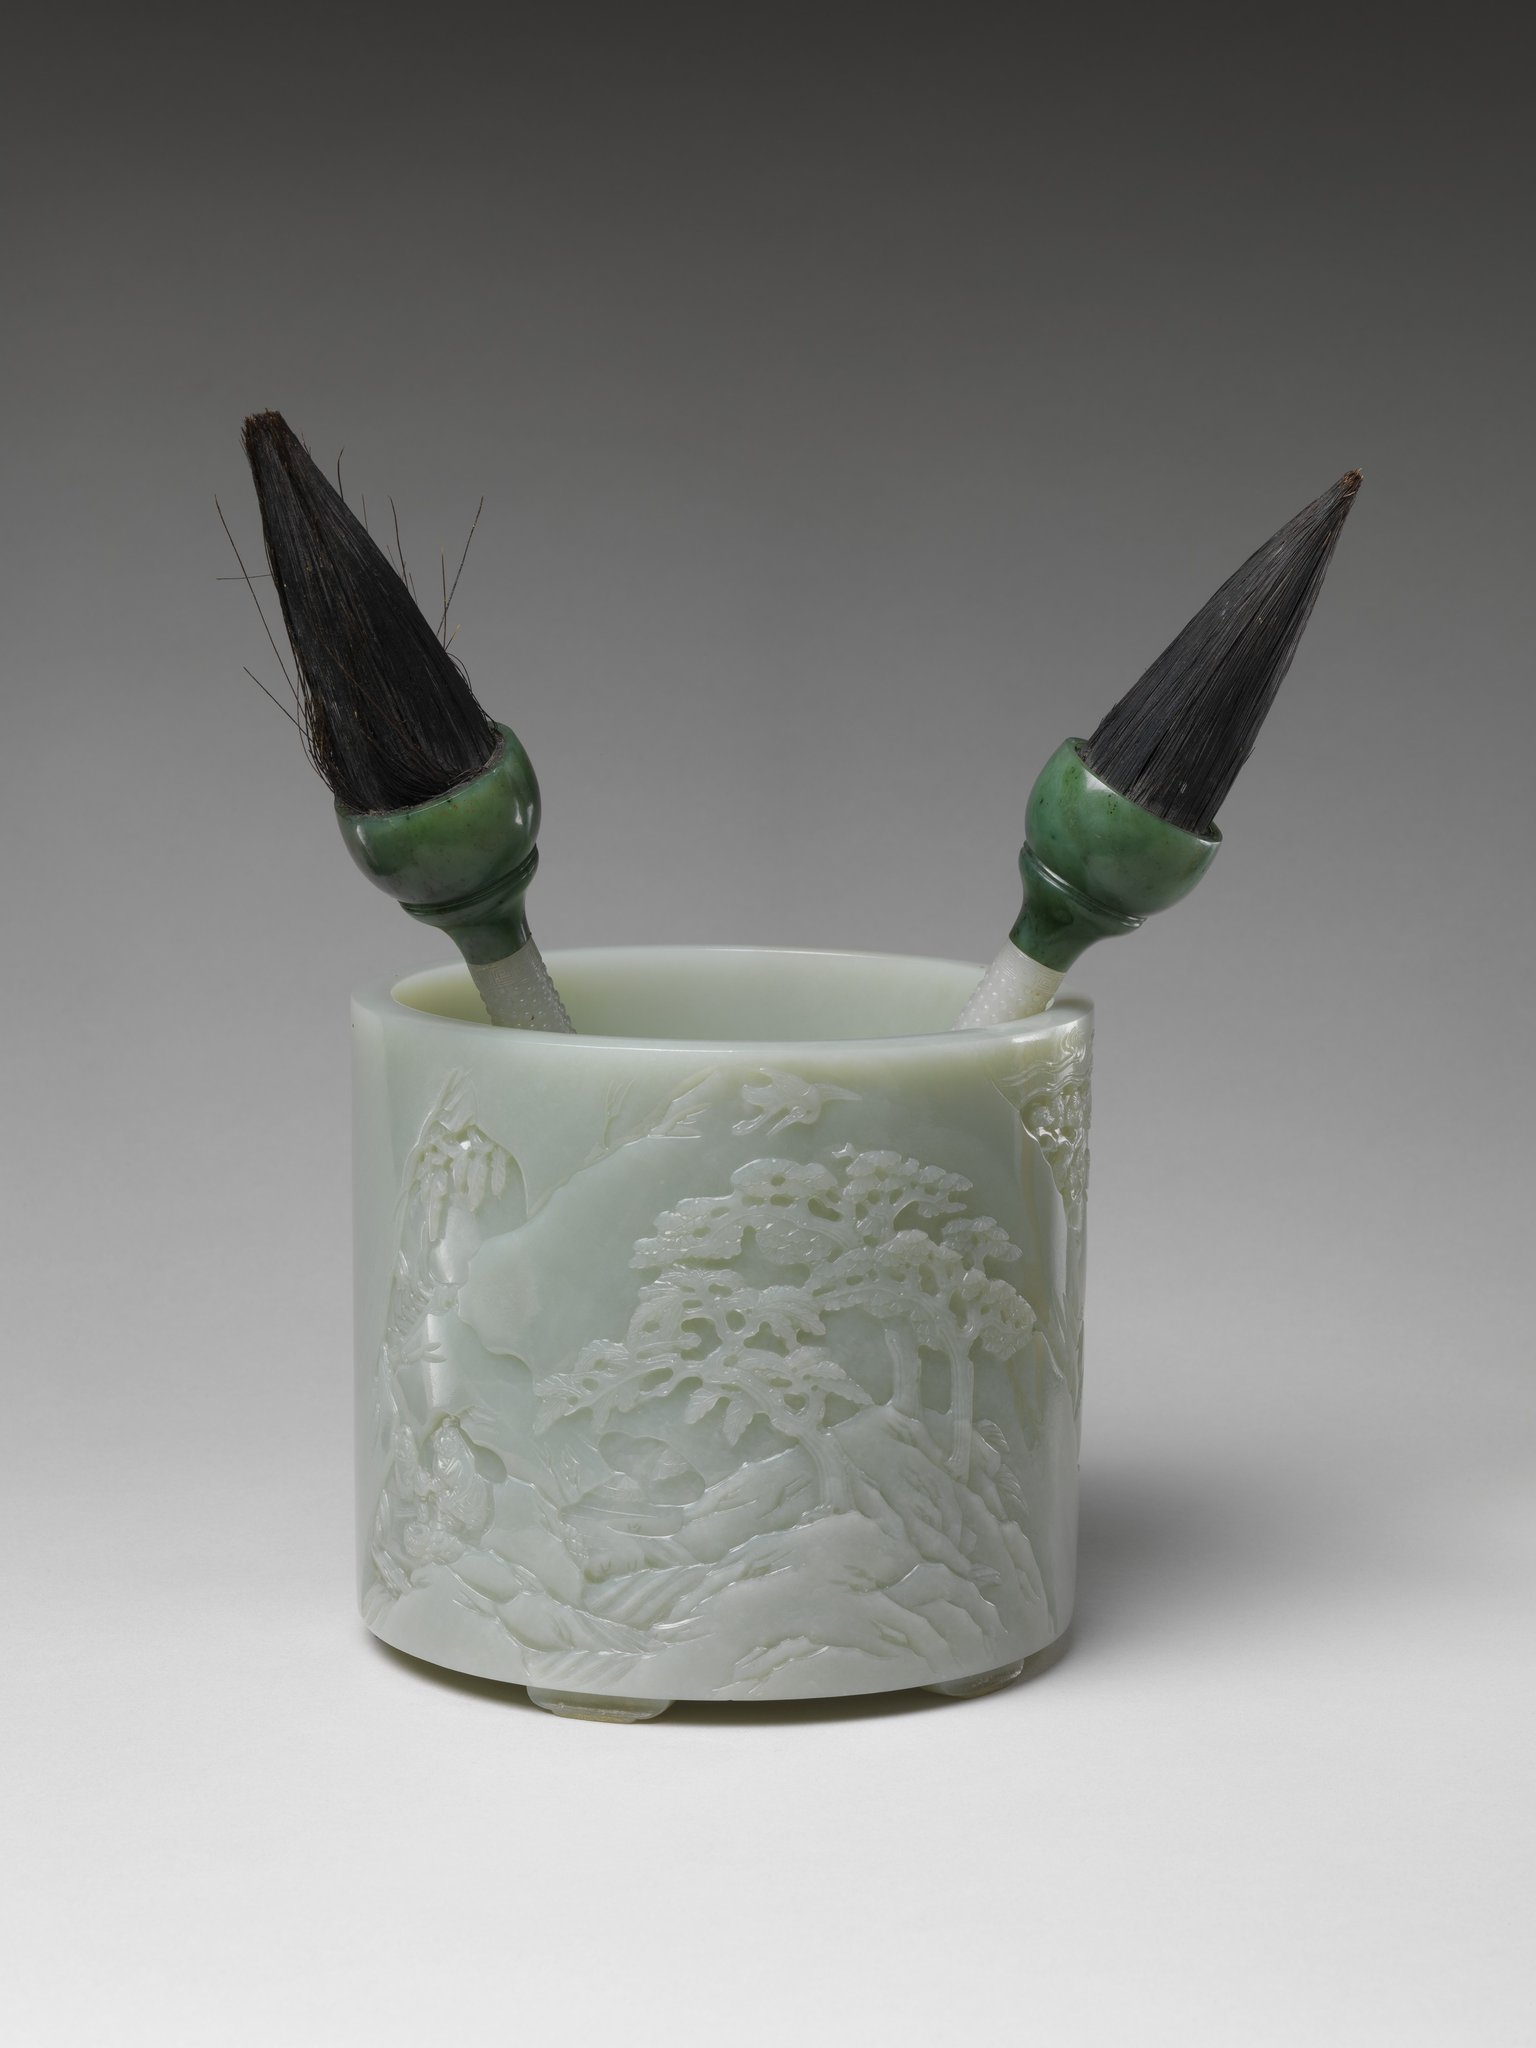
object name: brush holder with two brush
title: Brush holder with two brushes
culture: chinese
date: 1701-1800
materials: jade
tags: trees